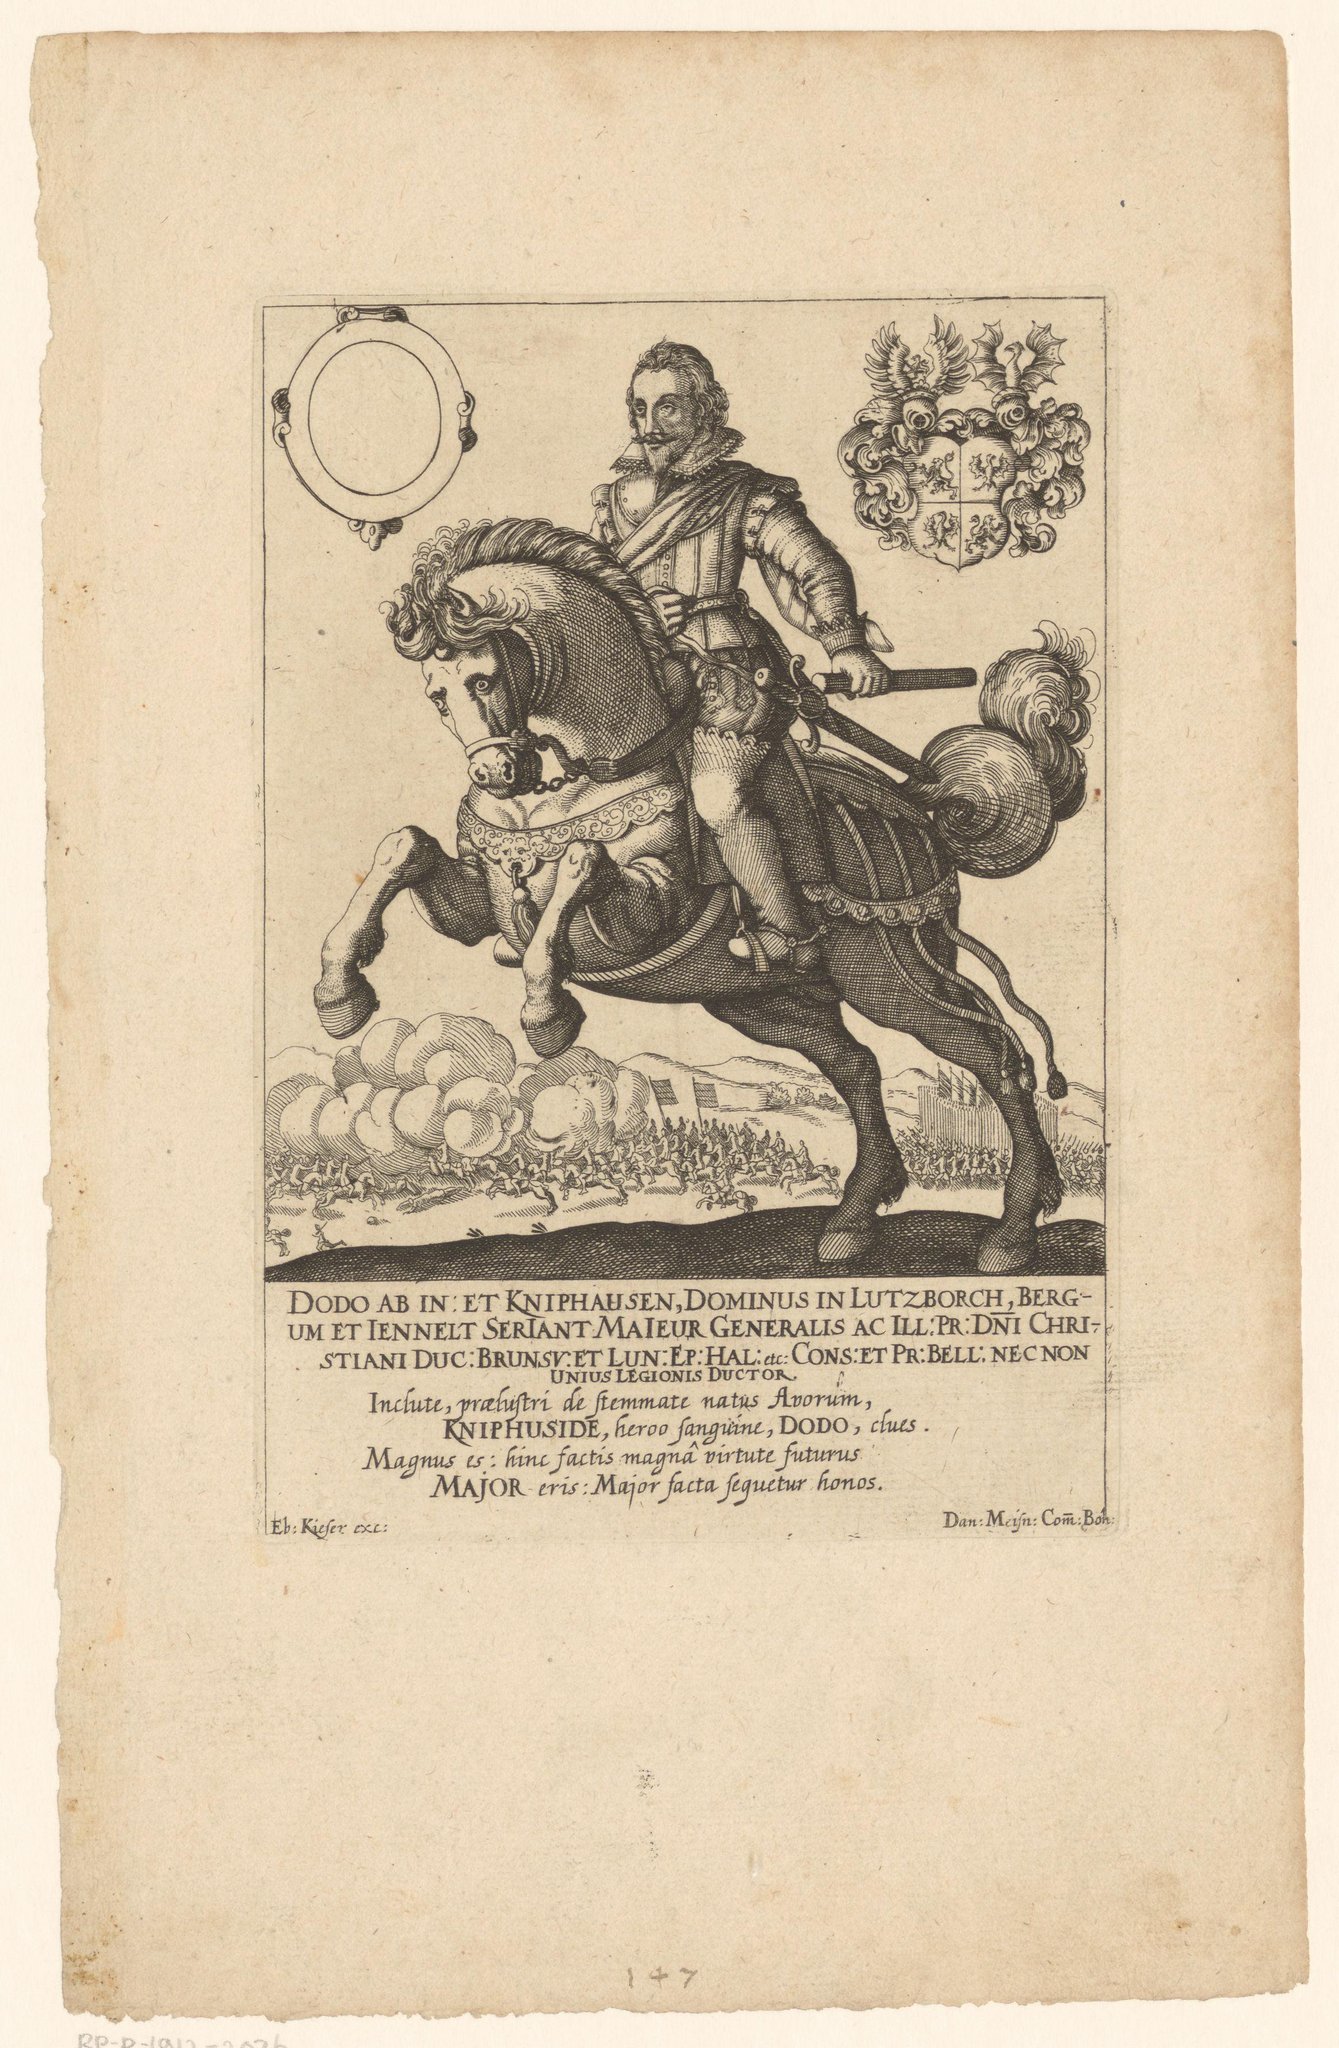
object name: print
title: Portret van Dodo von Knyphausen zu Innhausen te paard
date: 1593-1625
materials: paper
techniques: engraving, etching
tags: germany, commander-in-chief, general, marshal, historical persons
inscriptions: collector's mark: Lugt 2228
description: Daniel Meisner's signatuur eindigt met zijn geboortestad Chomutov (Komotau) in Bohemen, en wordt vaak genoteerd als D.M.C.B.